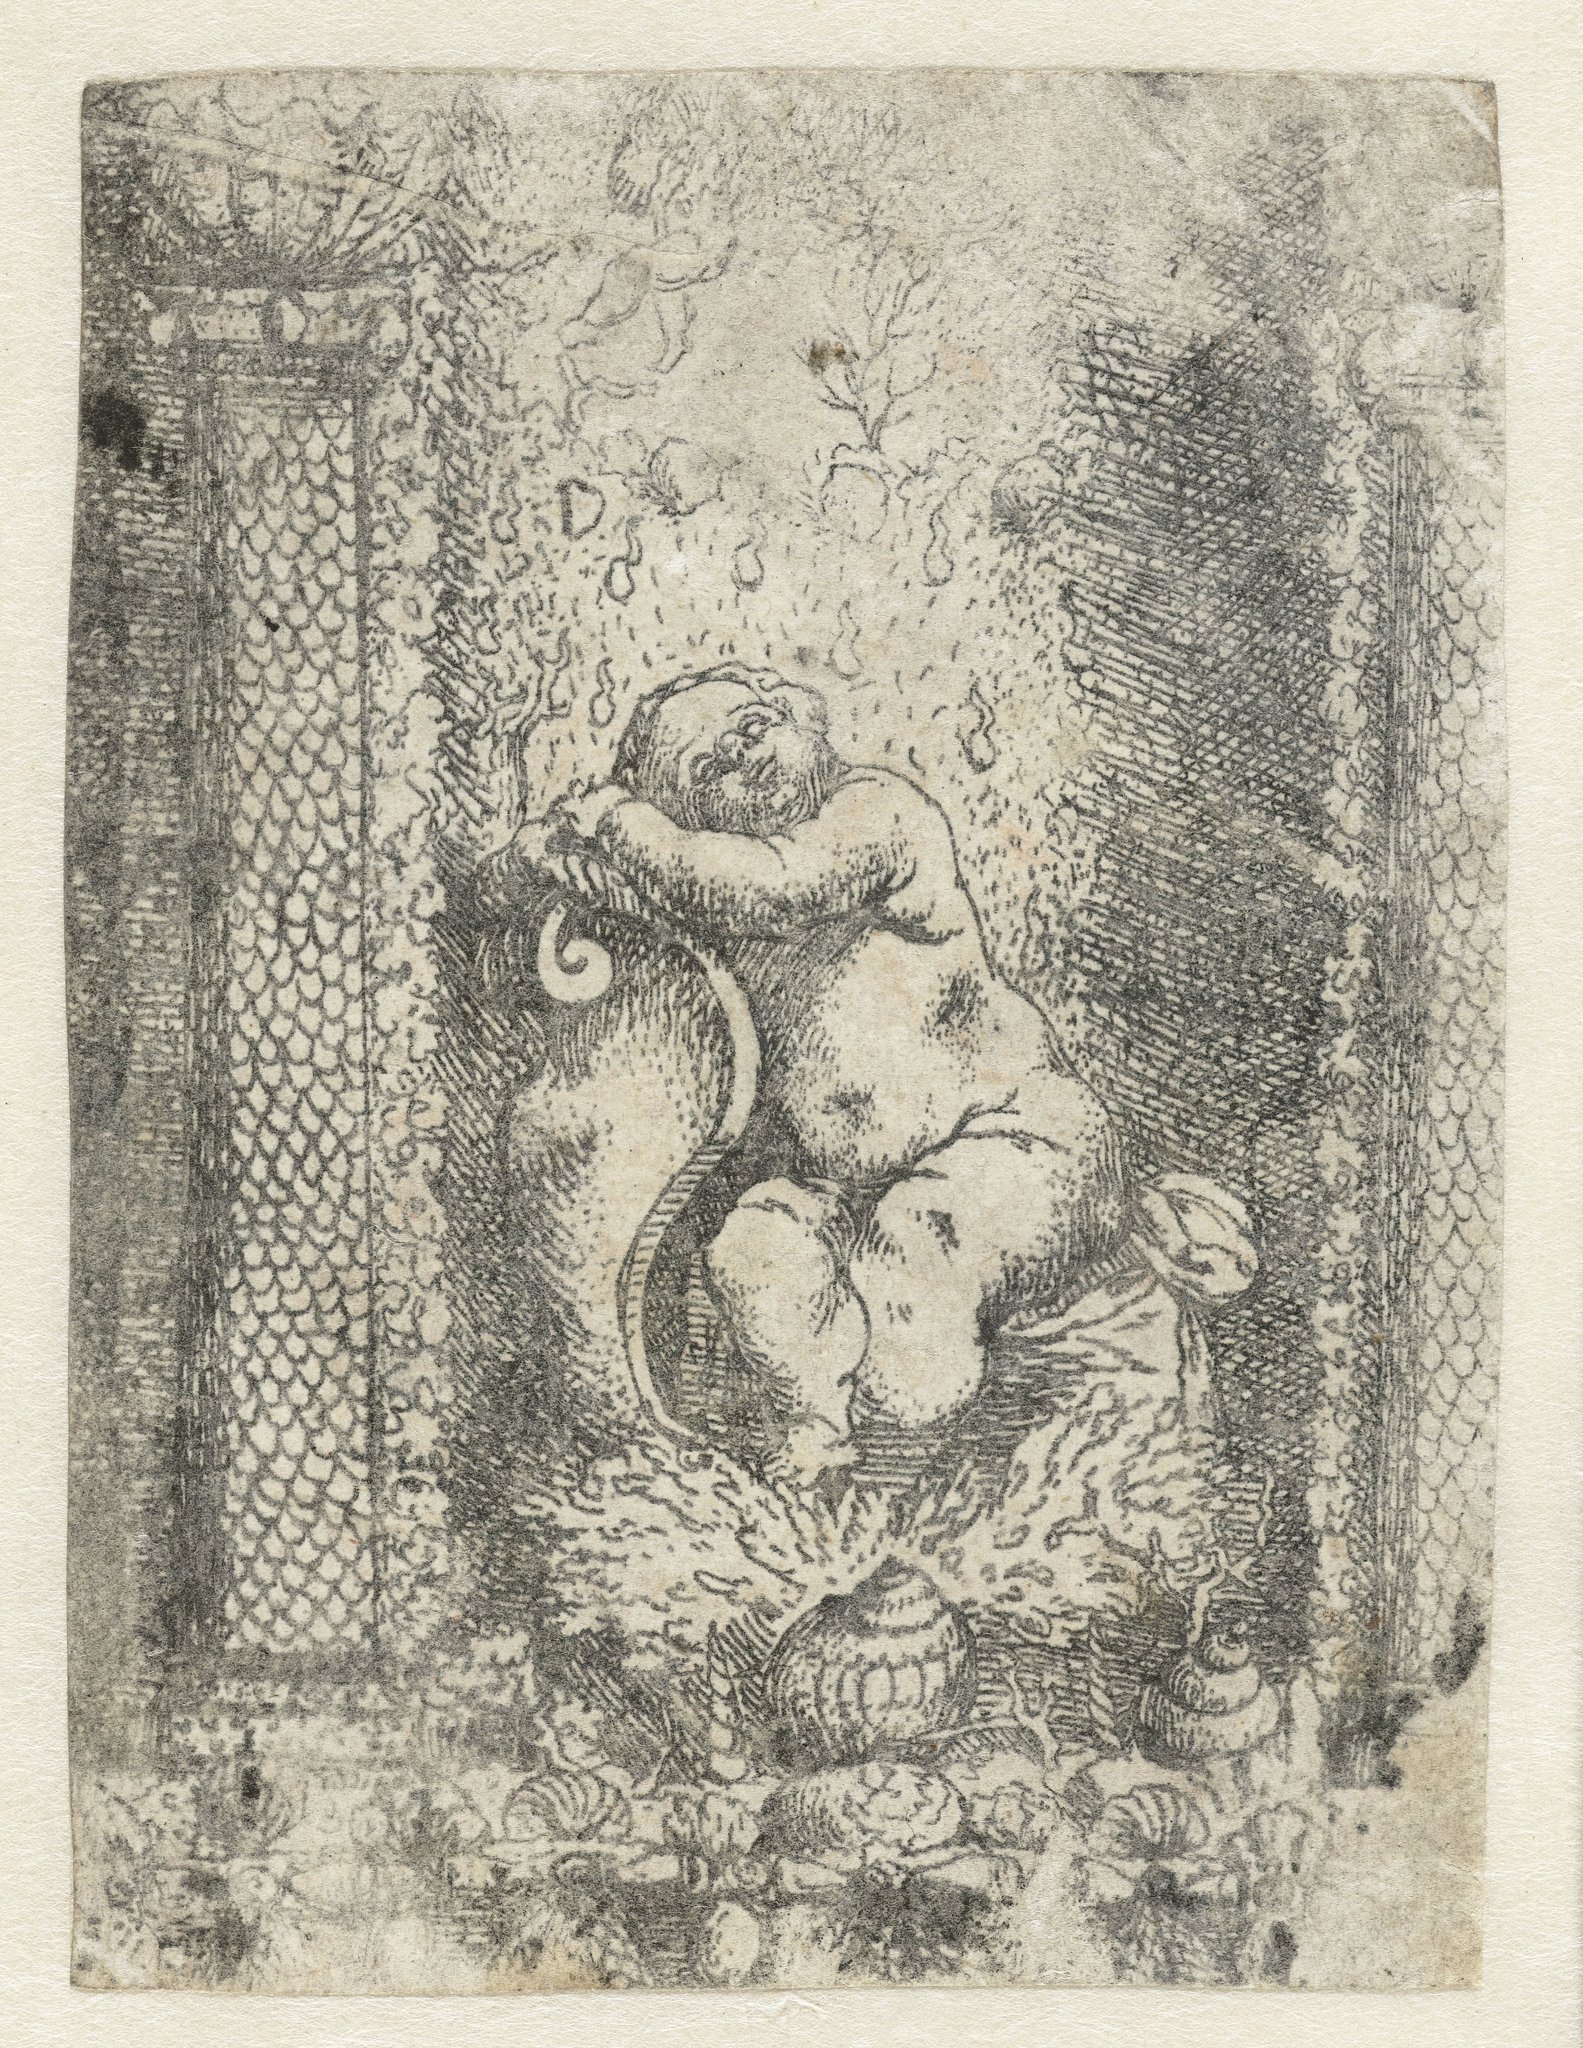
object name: print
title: Slapende putto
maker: Anonymous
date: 1500-1525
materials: paper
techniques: etching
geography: germany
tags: cupids: 'amores', 'amoretti', 'putti'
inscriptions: collector's mark: Lugt 240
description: Slapende putto, zittend in een schelpachtige stoel tussen twee pilaren en omringd door schelpen, zeewier en koraal.